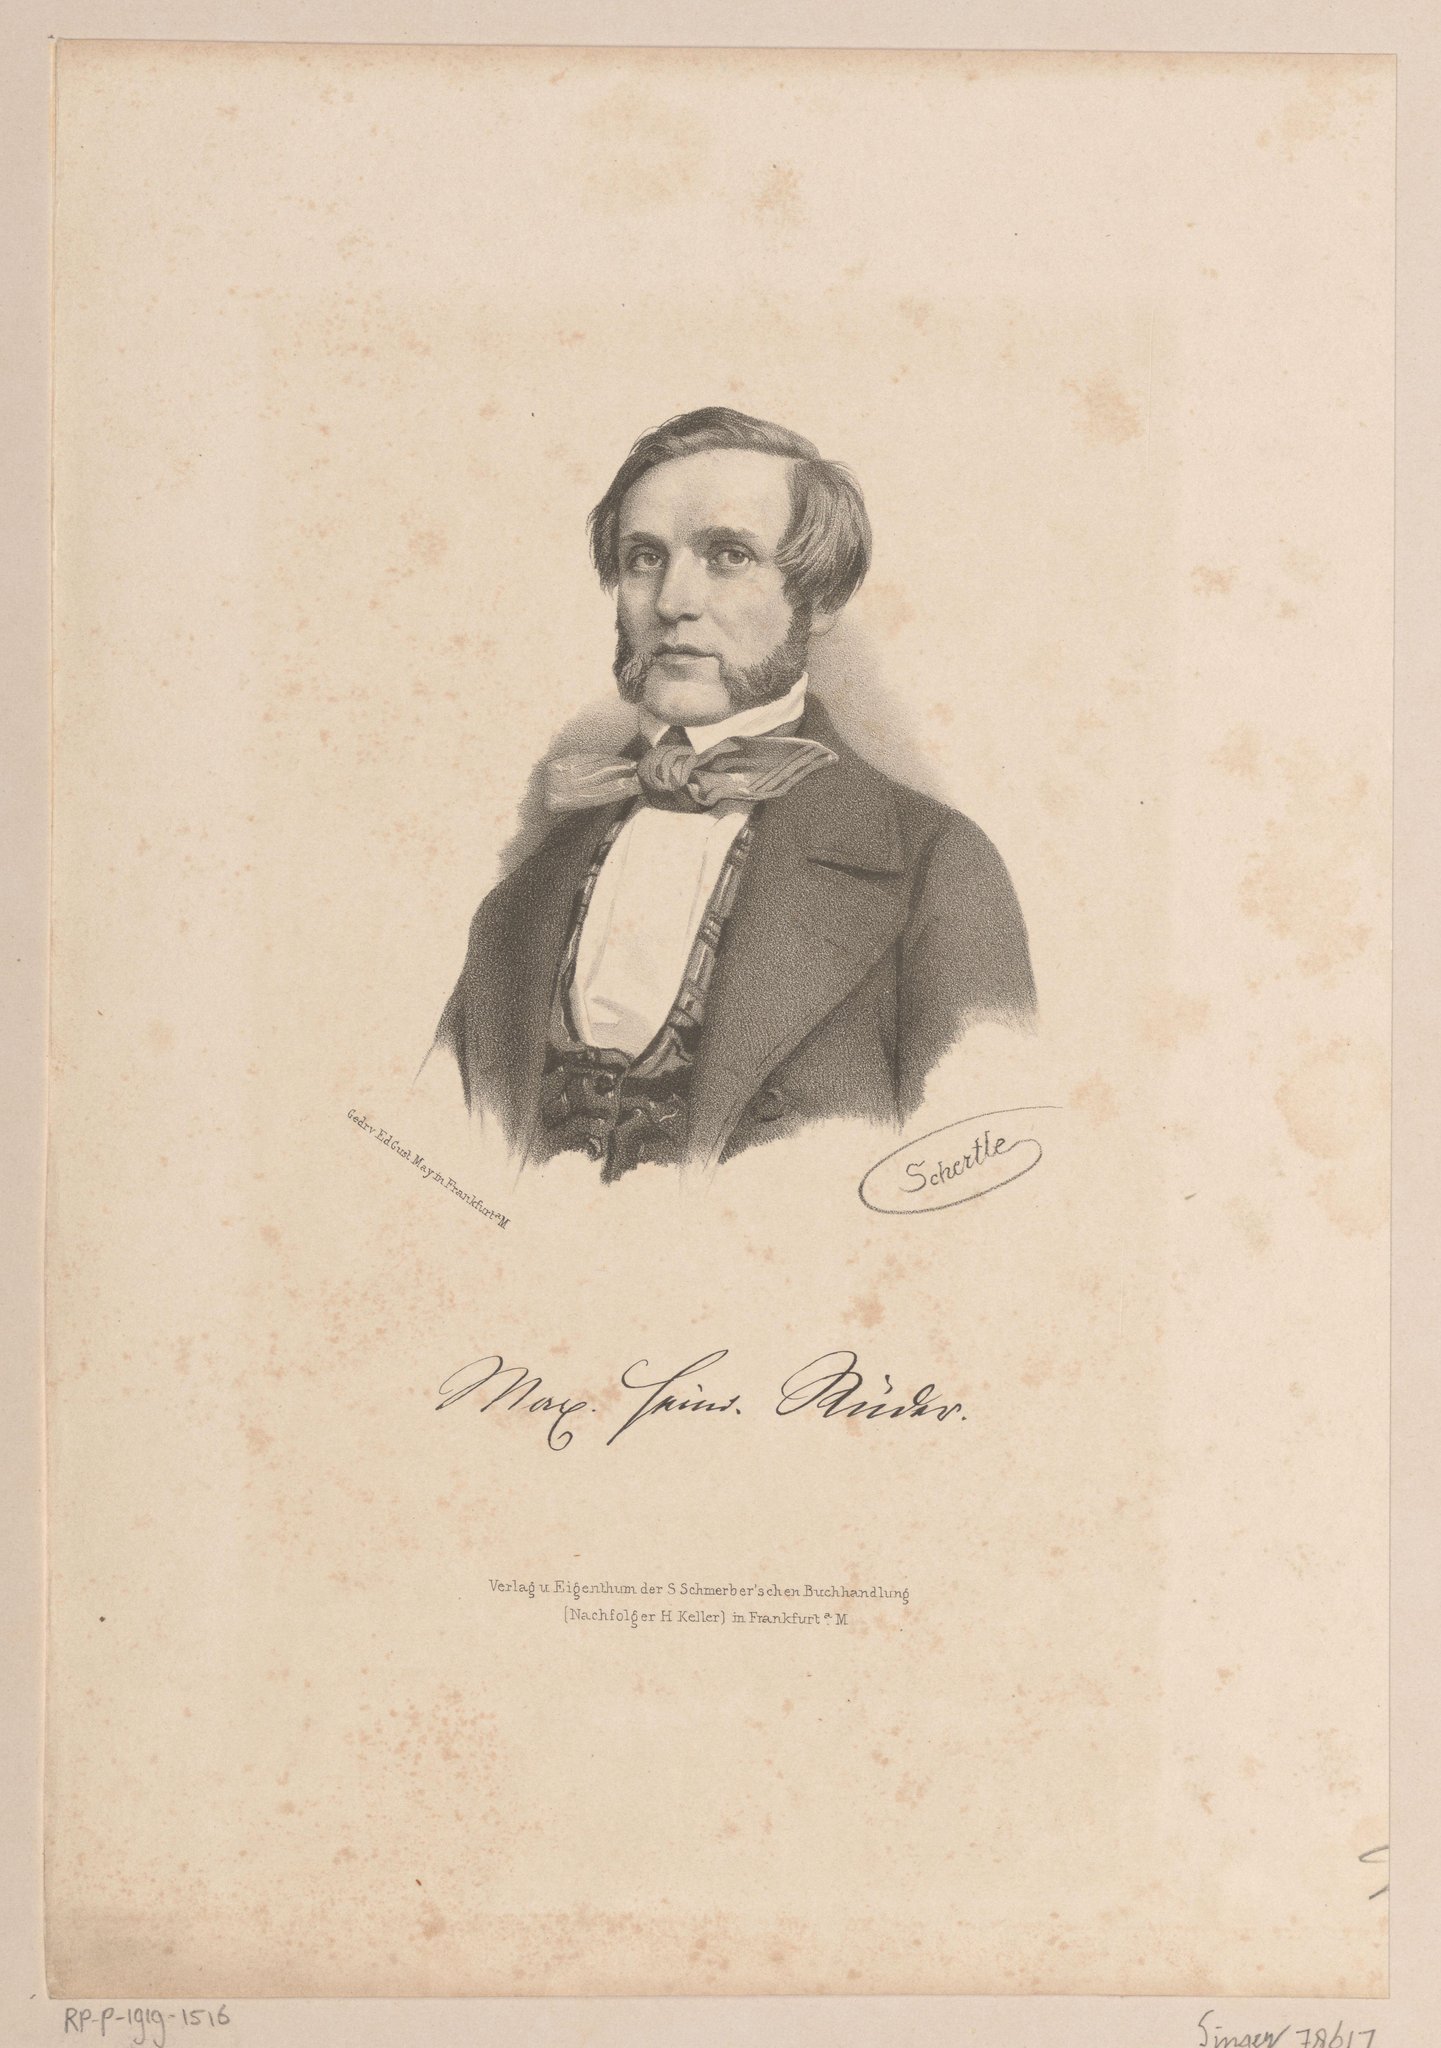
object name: print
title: Portret van Maximilian Heinrich Rüder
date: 1845-1884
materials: paper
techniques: lithograph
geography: frankfurt am main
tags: politician, historical persons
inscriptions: collector's mark: Lugt 2228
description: Onder het portret een facsimile van de handtekening van de geportretteerde.